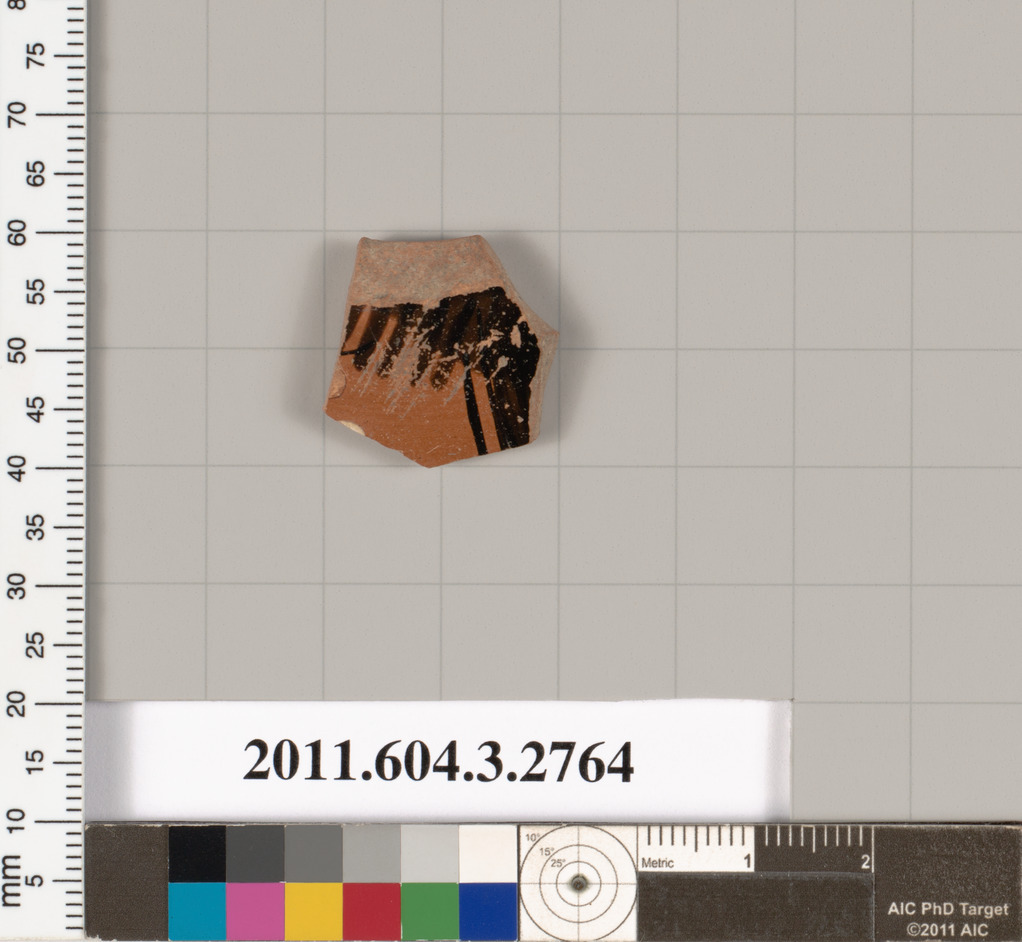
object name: oinochoe fragment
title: Terracotta fragment of an oinochoe (jug)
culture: greek, attic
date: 534-468 BCE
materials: terracotta